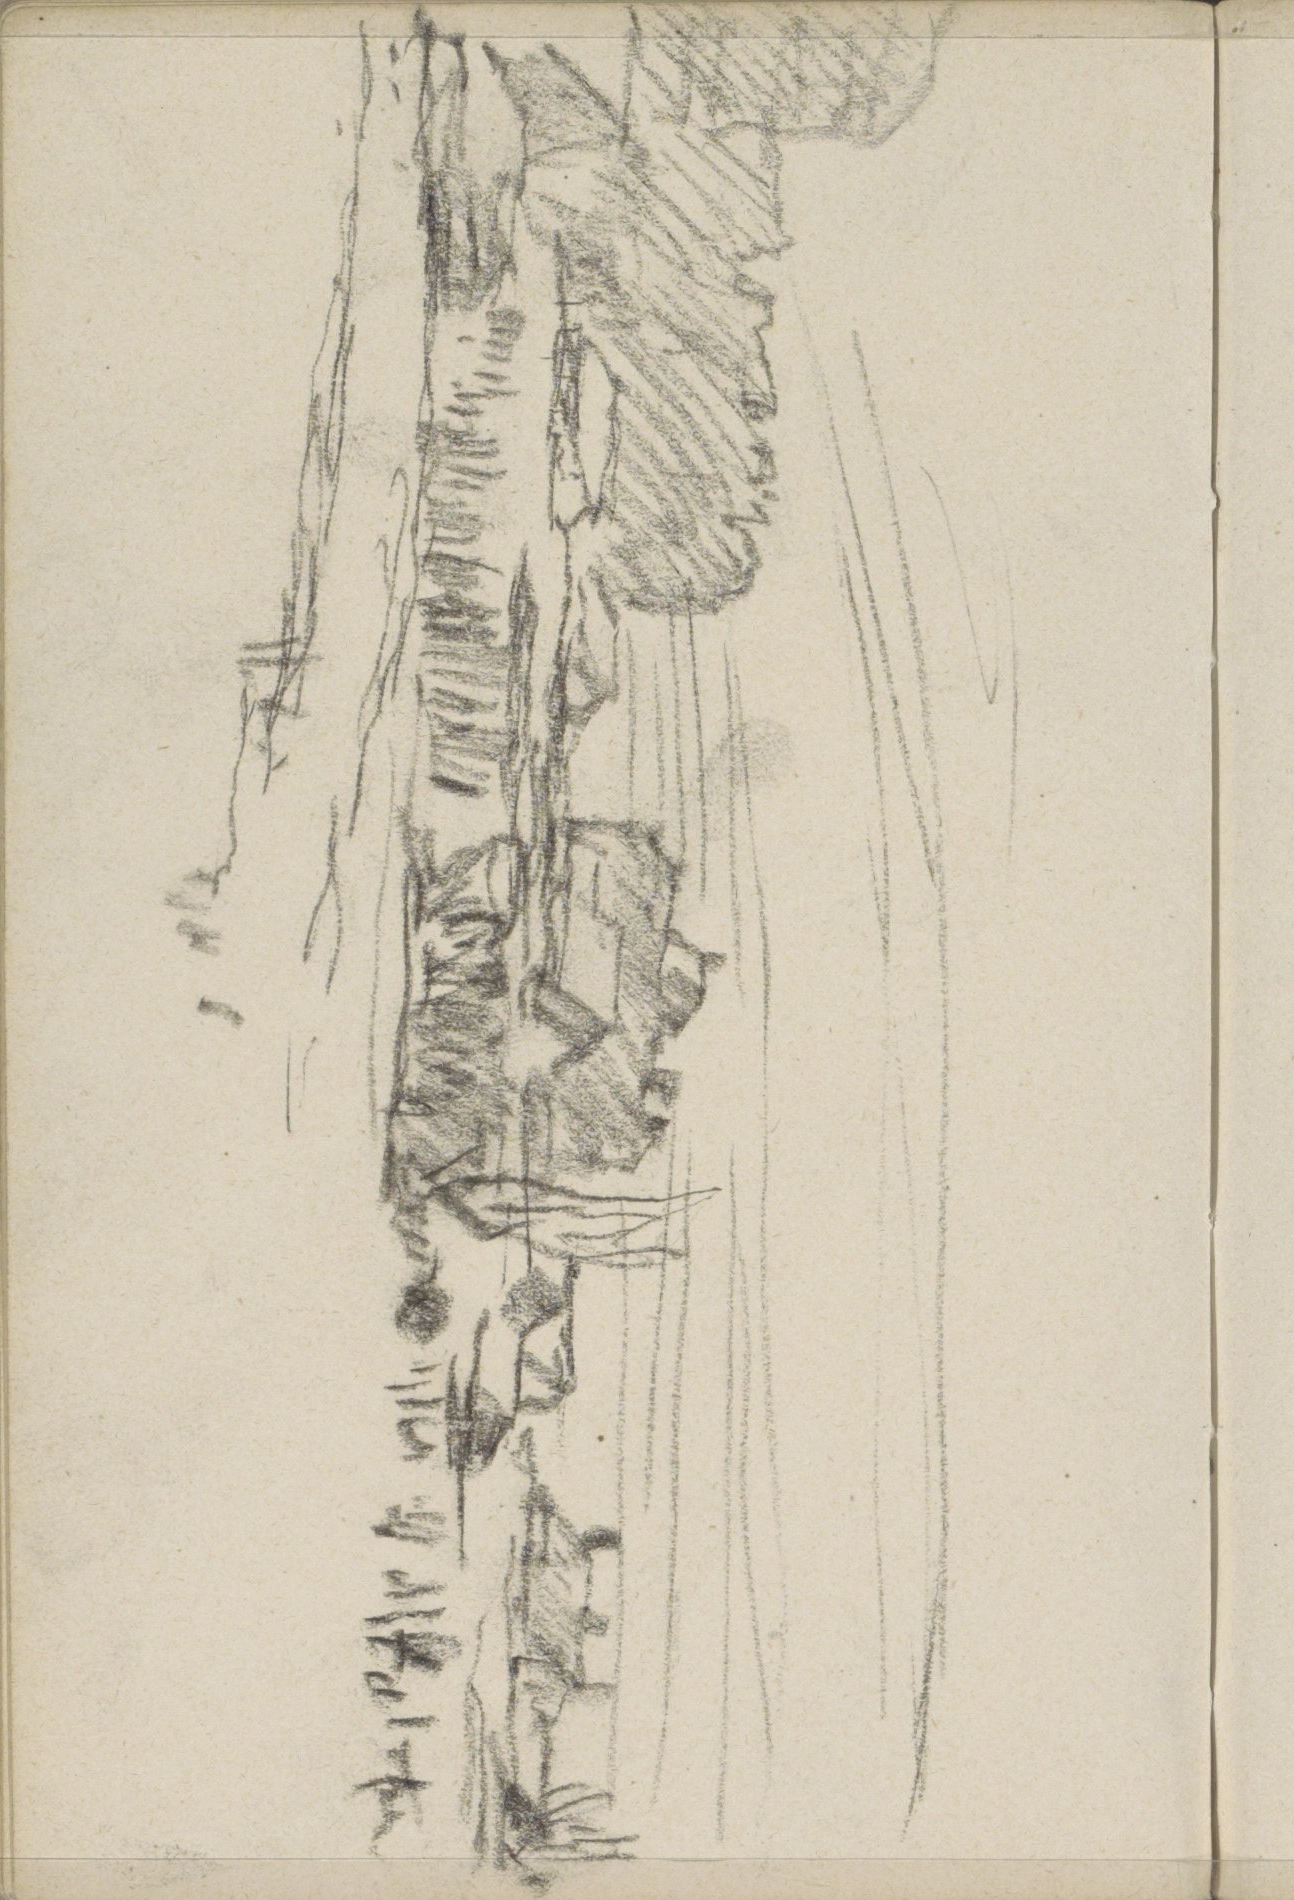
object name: sketchbook leaf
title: Landschap met bebouwing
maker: george hendrik breitner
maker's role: draughtsman, painter, print maker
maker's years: 1857-1923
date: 1914-1923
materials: chalk, paper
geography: north holland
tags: landscapes, rural housing, e.g. country-house, villa, cottage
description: Landschap met bebouwing. Pagina 65 uit een schetsboek met 43 bladen vervaardigd te Amsterdam.